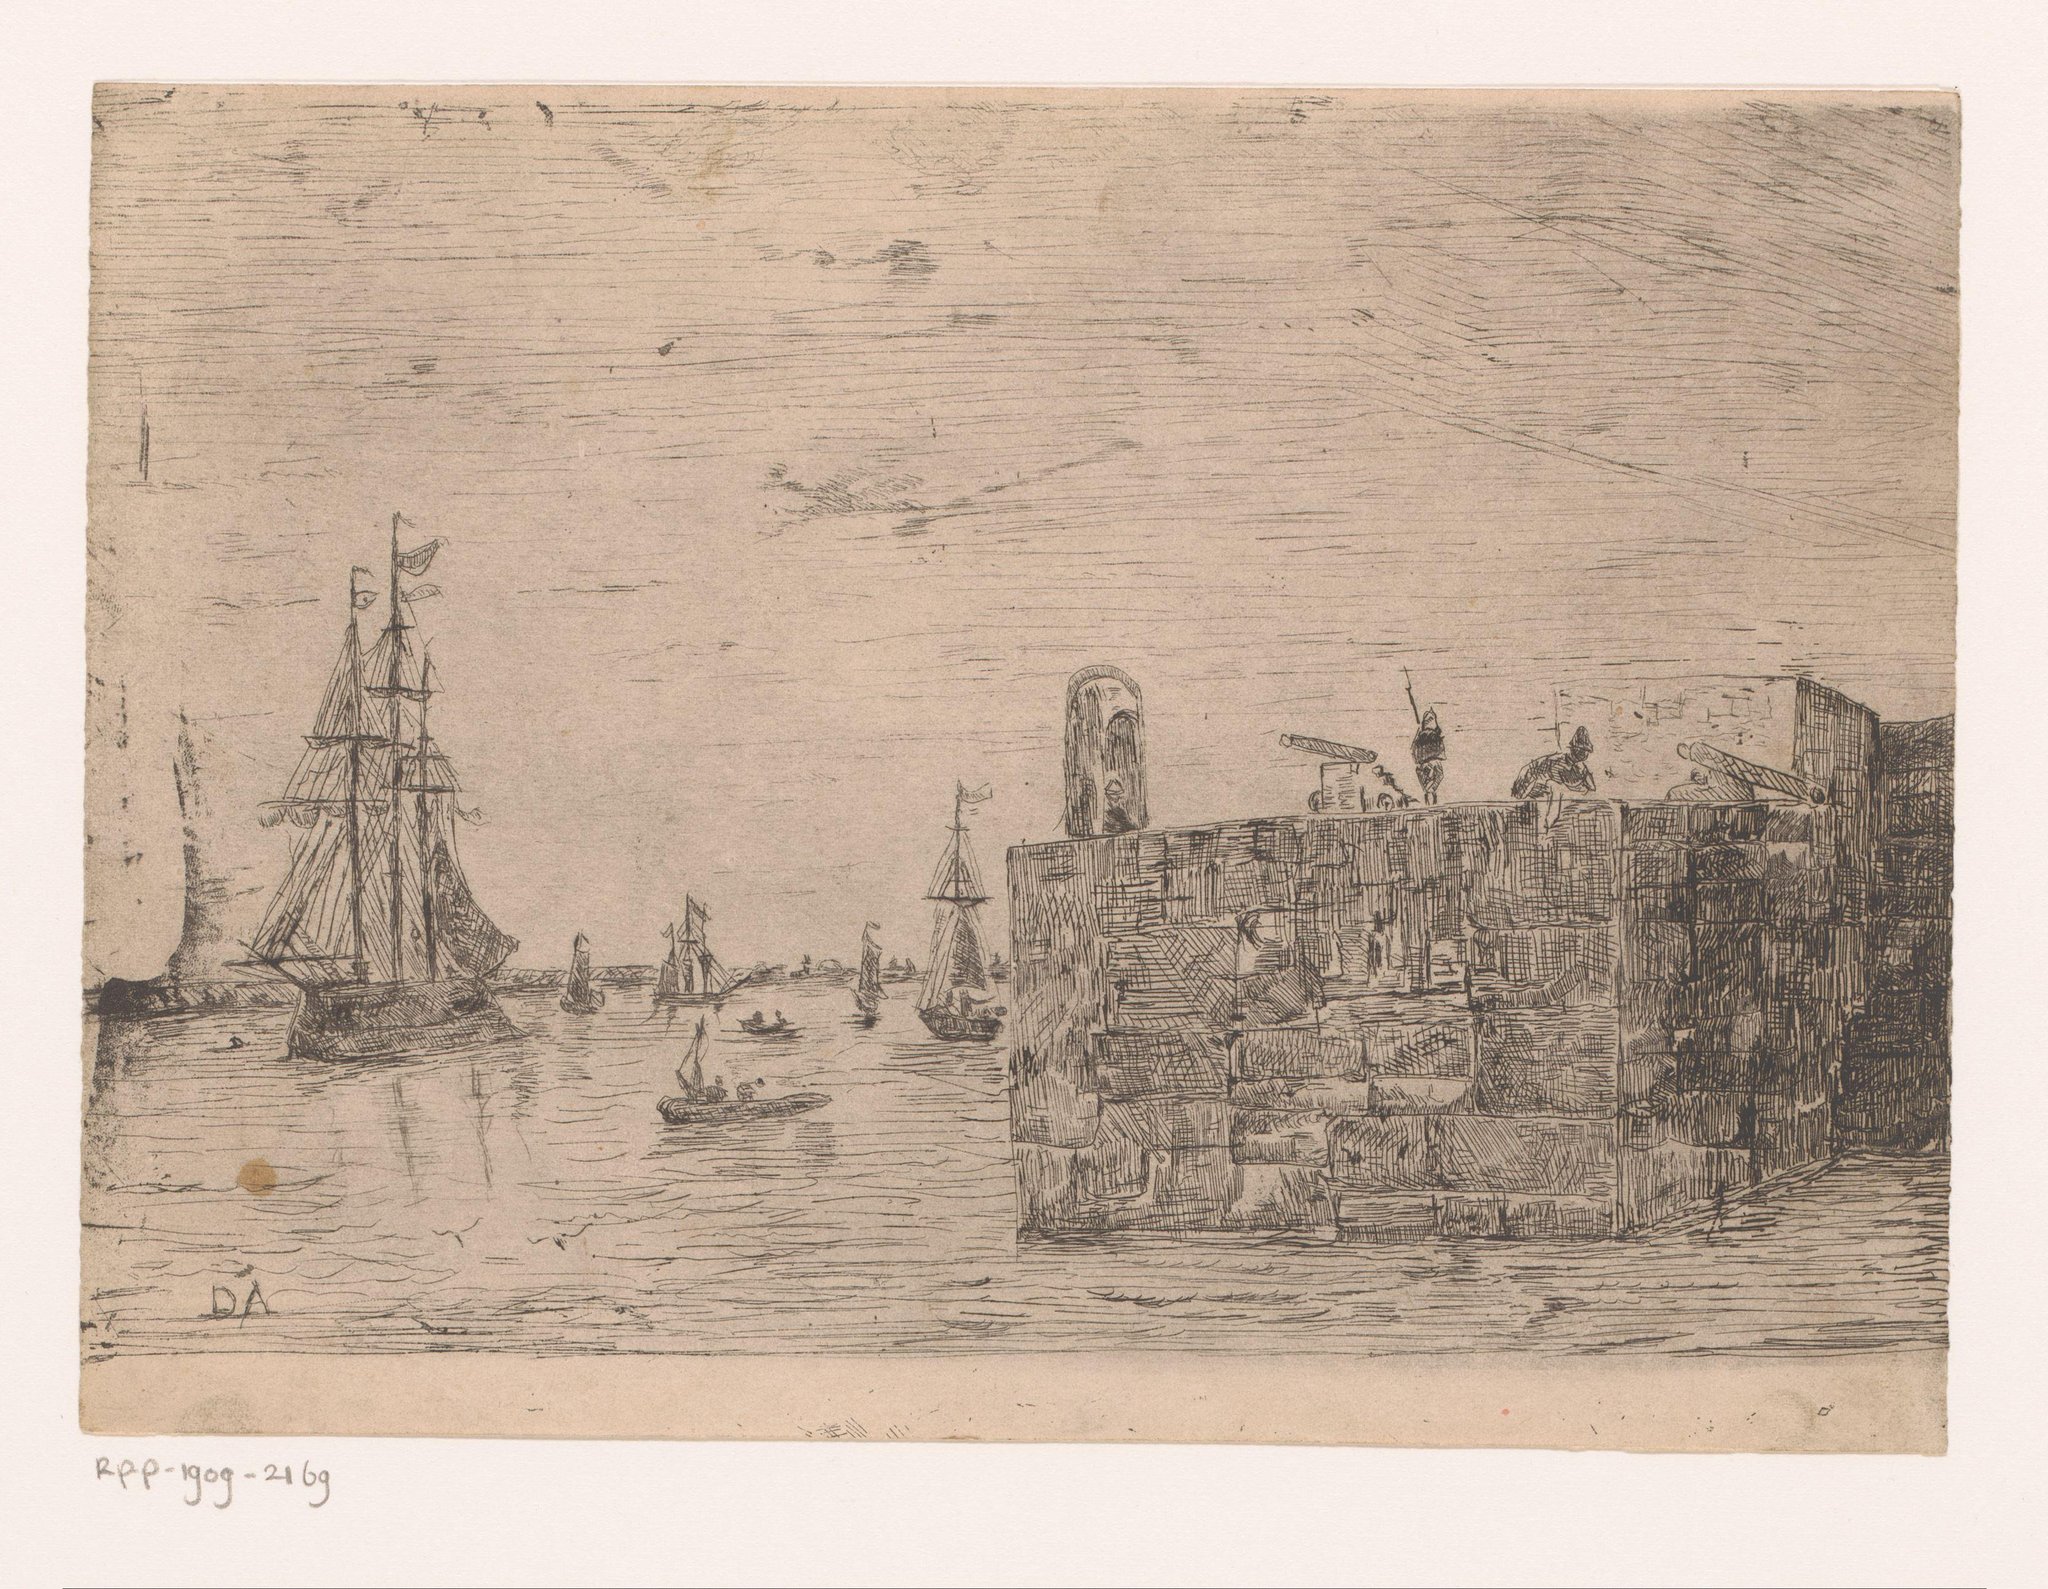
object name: print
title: Haven van La Goulette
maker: vicomte arthur-jean le bailly dinghuem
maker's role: print maker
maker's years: 1839-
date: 1875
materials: paper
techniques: etching, intaglio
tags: sailing-ship, sailing-boat, pier, quay, wharf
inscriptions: collector's mark: Lugt 2228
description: Onderdeel van een serie van twaalf prenten.